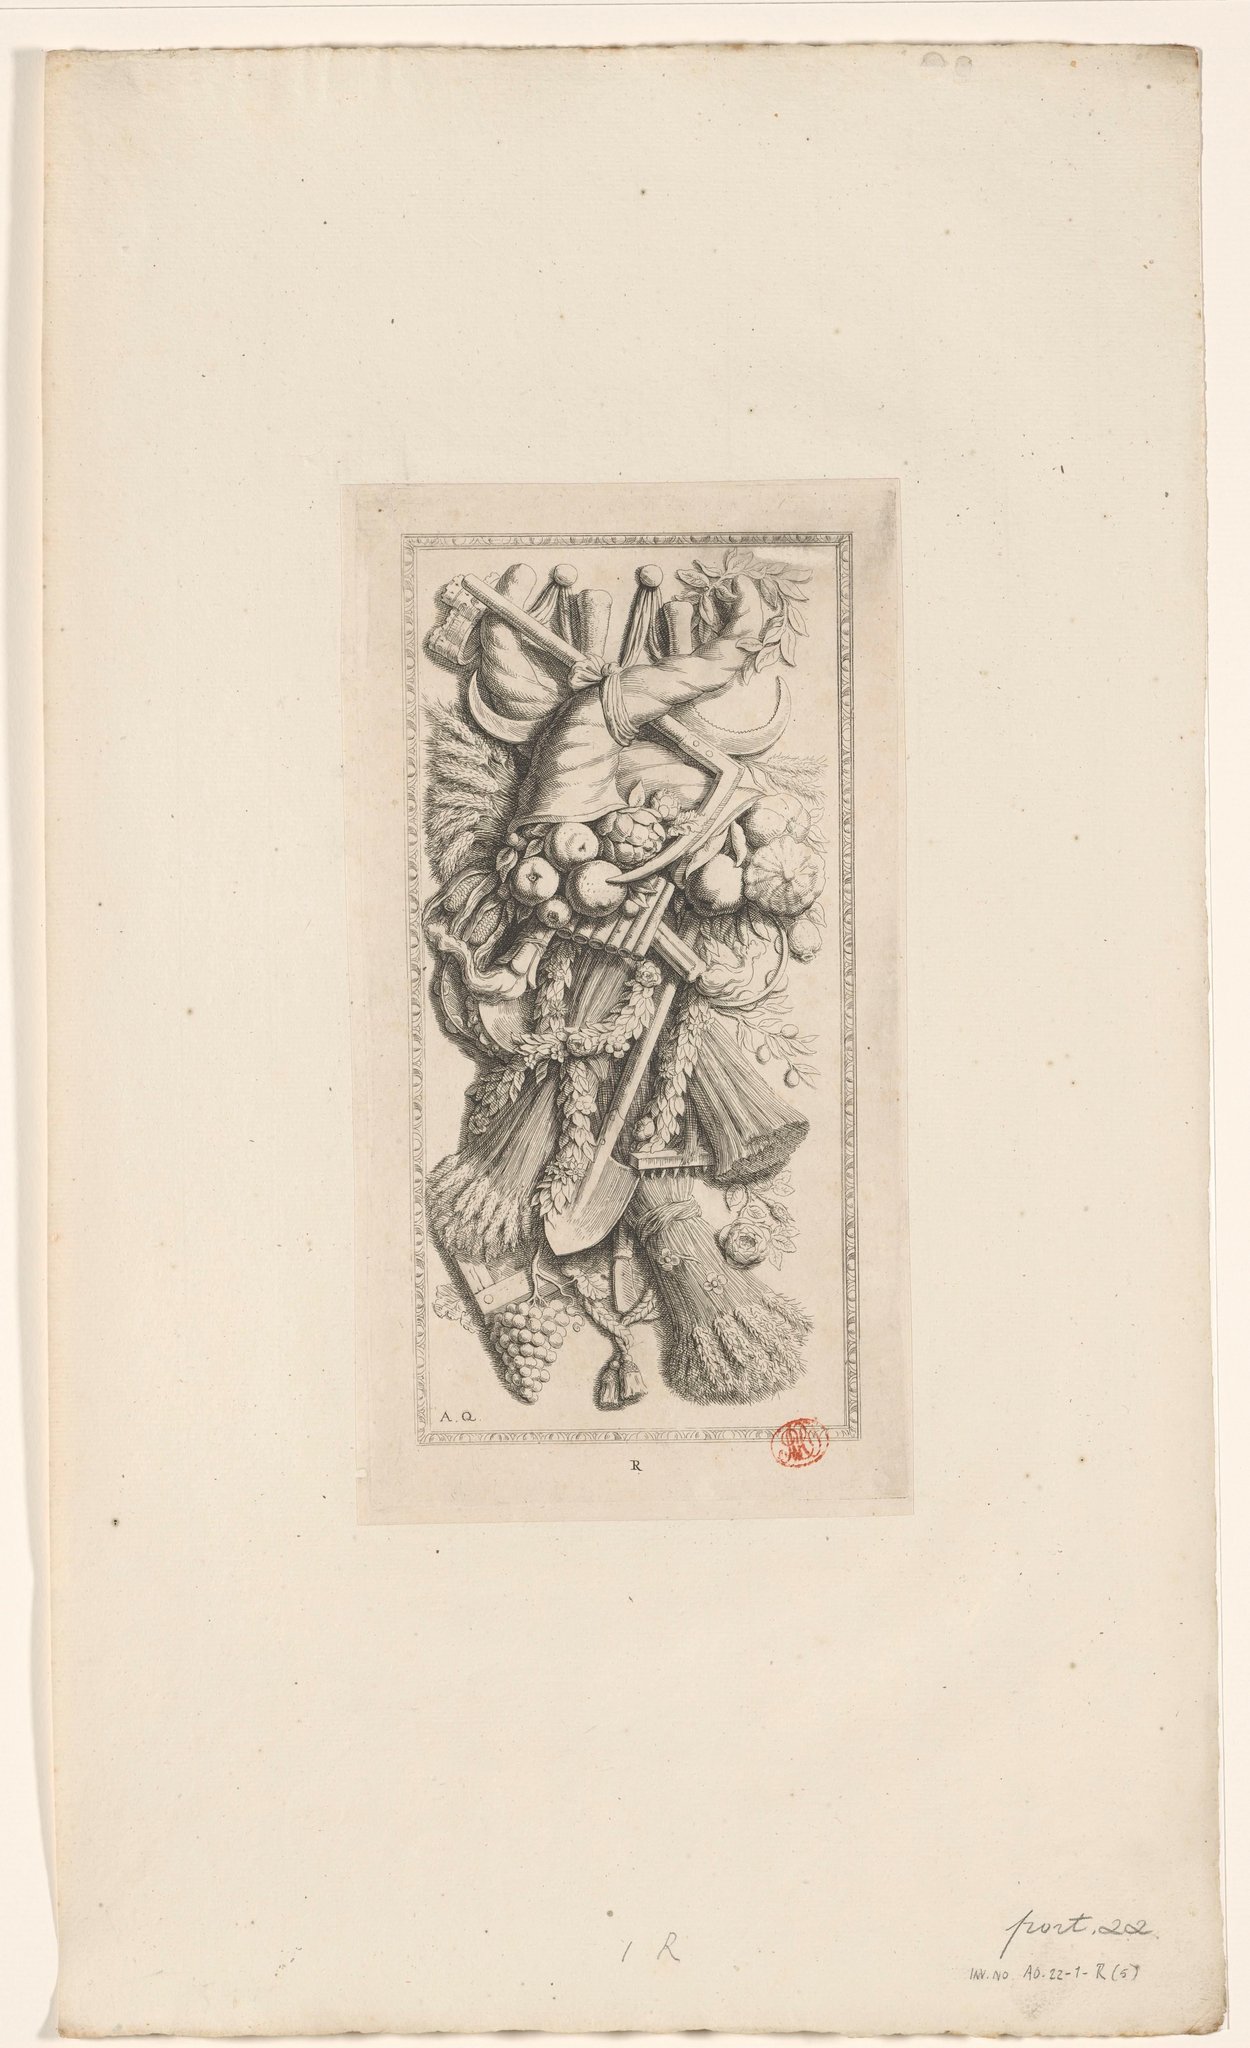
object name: book illustration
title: Reliëf met attributen van Cybele voor op piëdestal in de oostelijke galerij van het Stadhuis op de Dam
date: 1655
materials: paper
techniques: engraving, etching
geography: amsterdam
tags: 'cornucopia', horn of plenty, fruits and vegetables ~ ornament, agricultural implements, attributes of cybele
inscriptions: collector's mark: Lugt 195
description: Prent gebruikt in: Prima pars. Praecipuarum effigierum ac ornamentorum, amplissimae Curiae Amstelrodamensis (…) / Het eerste deel. Van de voornaemste Statuen ende Ciraten, vant konstijck Stadhuys van Amstelredam, tmeeste in marmer gemaeckt, door Artus Quellinus, Beelthouwer der voorseyde Stadt / La Premier Partie. De plusieurs Figures et ornements, de la Maison de Ville d'Amsterdam (…). Amsterdam: Artus Quellinus (I), 1655. Zie RP-P-AO-22-1-1 voor bijhorende titelpagina. Zie RP-P-AO-22-1-2 voor bijhorend register. Zie RP-P-AO-22-1A, RP-P-AO-22-1B, RP-P-AO-22-1C, RP-P-AO-22-1D-1, RP-P-AO-22-1D-2, RP-P-AO-22-1E, RP-P-AO-22-1F, RP-P-AO-22-1G, RP-P-AO-22-1H, RP-P-AO-22-1I, RP-P-AO-22-1K-1, RP-P-AO-22-1K-2, RP-P-AO-22-1K-3, RP-P-AO-22-1K-4, RP-P-AO-22-1K-5, RP-P-AO-22-1L-1, RP-P-AO-22-1L-2, RP-P-AO-22-1M-1, RP-P-AO-22-1M-2, RP-P-AO-22-1N-1, RP-P-AO-22-1N-2, RP-P-AO-22-1N-3, RP-P-AO-22-1N-4, RP-P-AO-22-1N-5, RP-P-AO-22-1O-1, RP-P-AO-22-1O-2, RP-P-AO-22-1O-3, RP-P-AO-22-1O-4, RP-P-AO-22-1P-1, RP-P-AO-22-1P-2, RP-P-AO-22-1P-3, RP-P-AO-22-1P-4, RP-P-AO-22-1Q-1, RP-P-AO-22-1Q-2, RP-P-AO-22-1Q-3, RP-P-AO-22-1Q-4, RP-P-AO-22-1R-1, RP-P-AO-22-1R-2, RP-P-AO-22-1R-3, RP-P-AO-22-1R-4, RP-P-AO-22-1S-1, RP-P-AO-22-1S-2, RP-P-AO-22-1S-3, RP-P-AO-22-1S-4, RP-P-AO-22-1S-5, RP-P-AO-22-1T-1 en RP-P-AO-22-1T-2 voor andere prenten uit deze publicatie. Zelfde staat van prent ook gebruikt in: Prima pars. Praecipuarum effigierum ac ornamentorum, amplissimae Curiae Amstelrodamensis (…) / Het eerste deel. Van de voornaemste Statuen ende Ciraten, vant konstijck Stadhuys van Amstelredam, tmeeste in marmer gemaeckt, door Artus Quellinus, Beelthouwer der voorseyde Stadt / La Premier Partie. De plusieurs Figures et ornements, de la Maison de Ville d'Amsterdam (…). Amsterdam: Frederik de Wit, 1665. Latere staat van prent ook gebruikt in: Architecture peinture et sculpture de la Maison de Ville d'Amsterdam, representee en CIX. figures en taille-douce (…). Amsterdam: David Mortier, 1719. En in: Architecture peinture et sculpture de la Maison de Ville d'Amsterdam, representee en CIX. figures en taille-douce (…). Amsterdam: Gerard Valck, 1719. En in: Bouw schilder en beeldhouwkonst, van het Stadhuis te Amsteldam, vertoont in CIX figuuren (…). Amsterdam: Covens & Mortier & Covens Jr., s.a. (1774-1783).